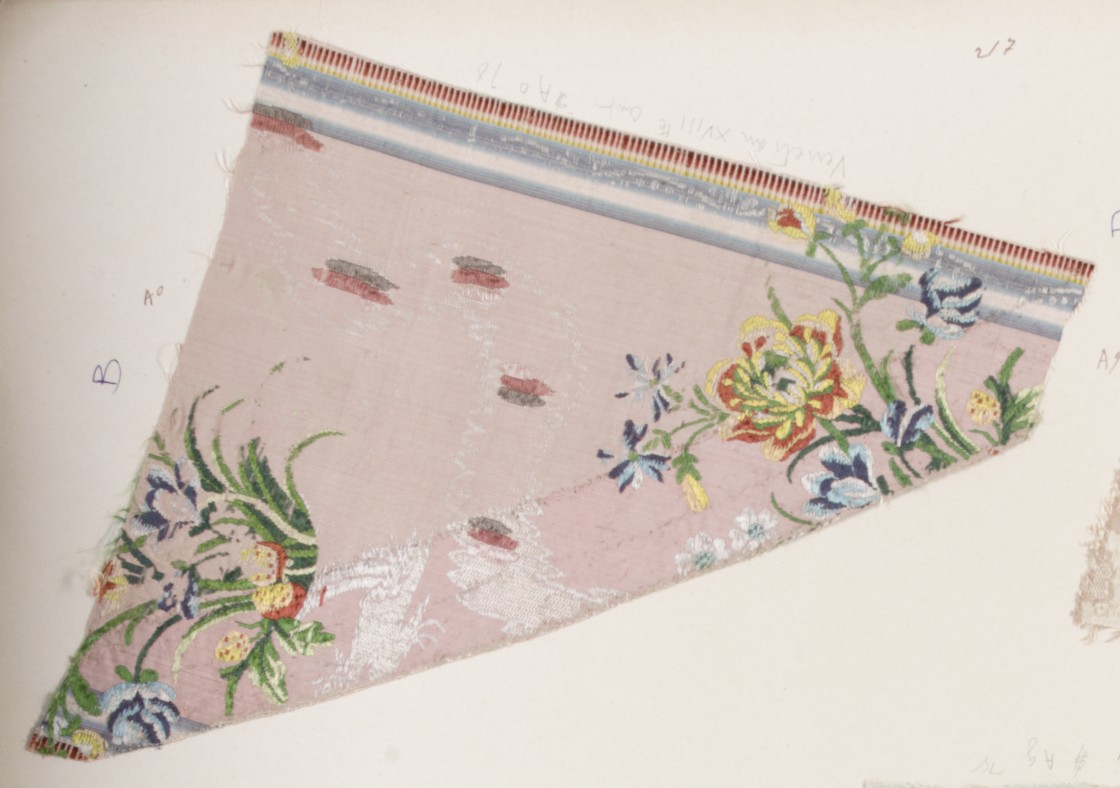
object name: fragment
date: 1701-1800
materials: silk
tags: flowers,leaves